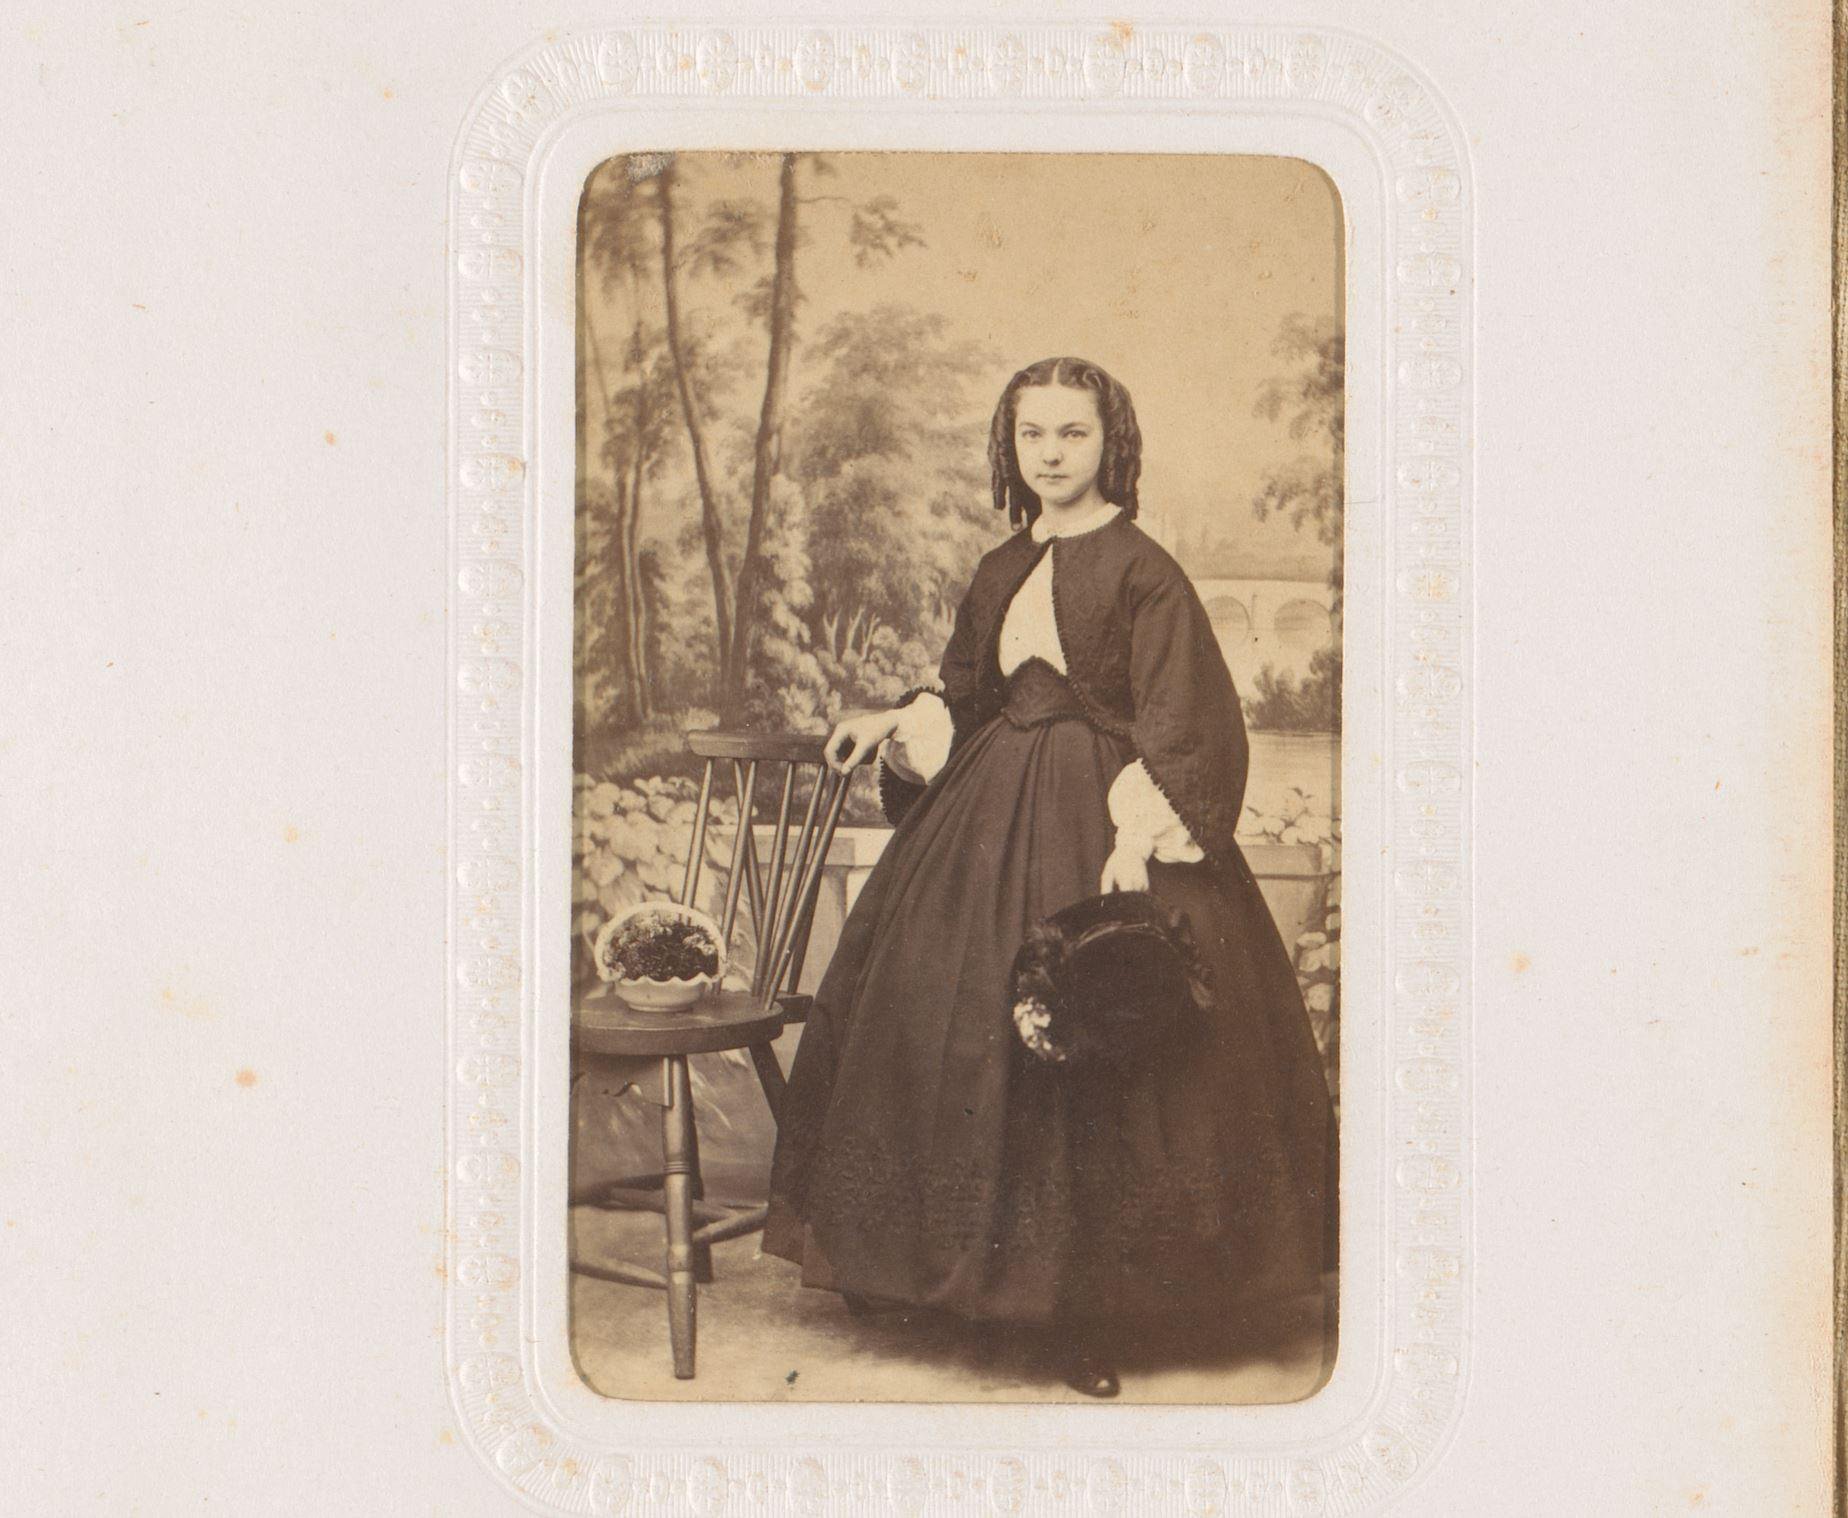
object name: photograph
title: Portret van een jonge vrouw met hoed in de hand, staand bij een stoel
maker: Anonymous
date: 1860-1900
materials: cardboard, photographic support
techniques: albumen print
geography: netherlands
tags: adolescent, young woman, maiden, historical persons - bb - woman, head-gear: hat, standing figure - aa - female human figure, chair